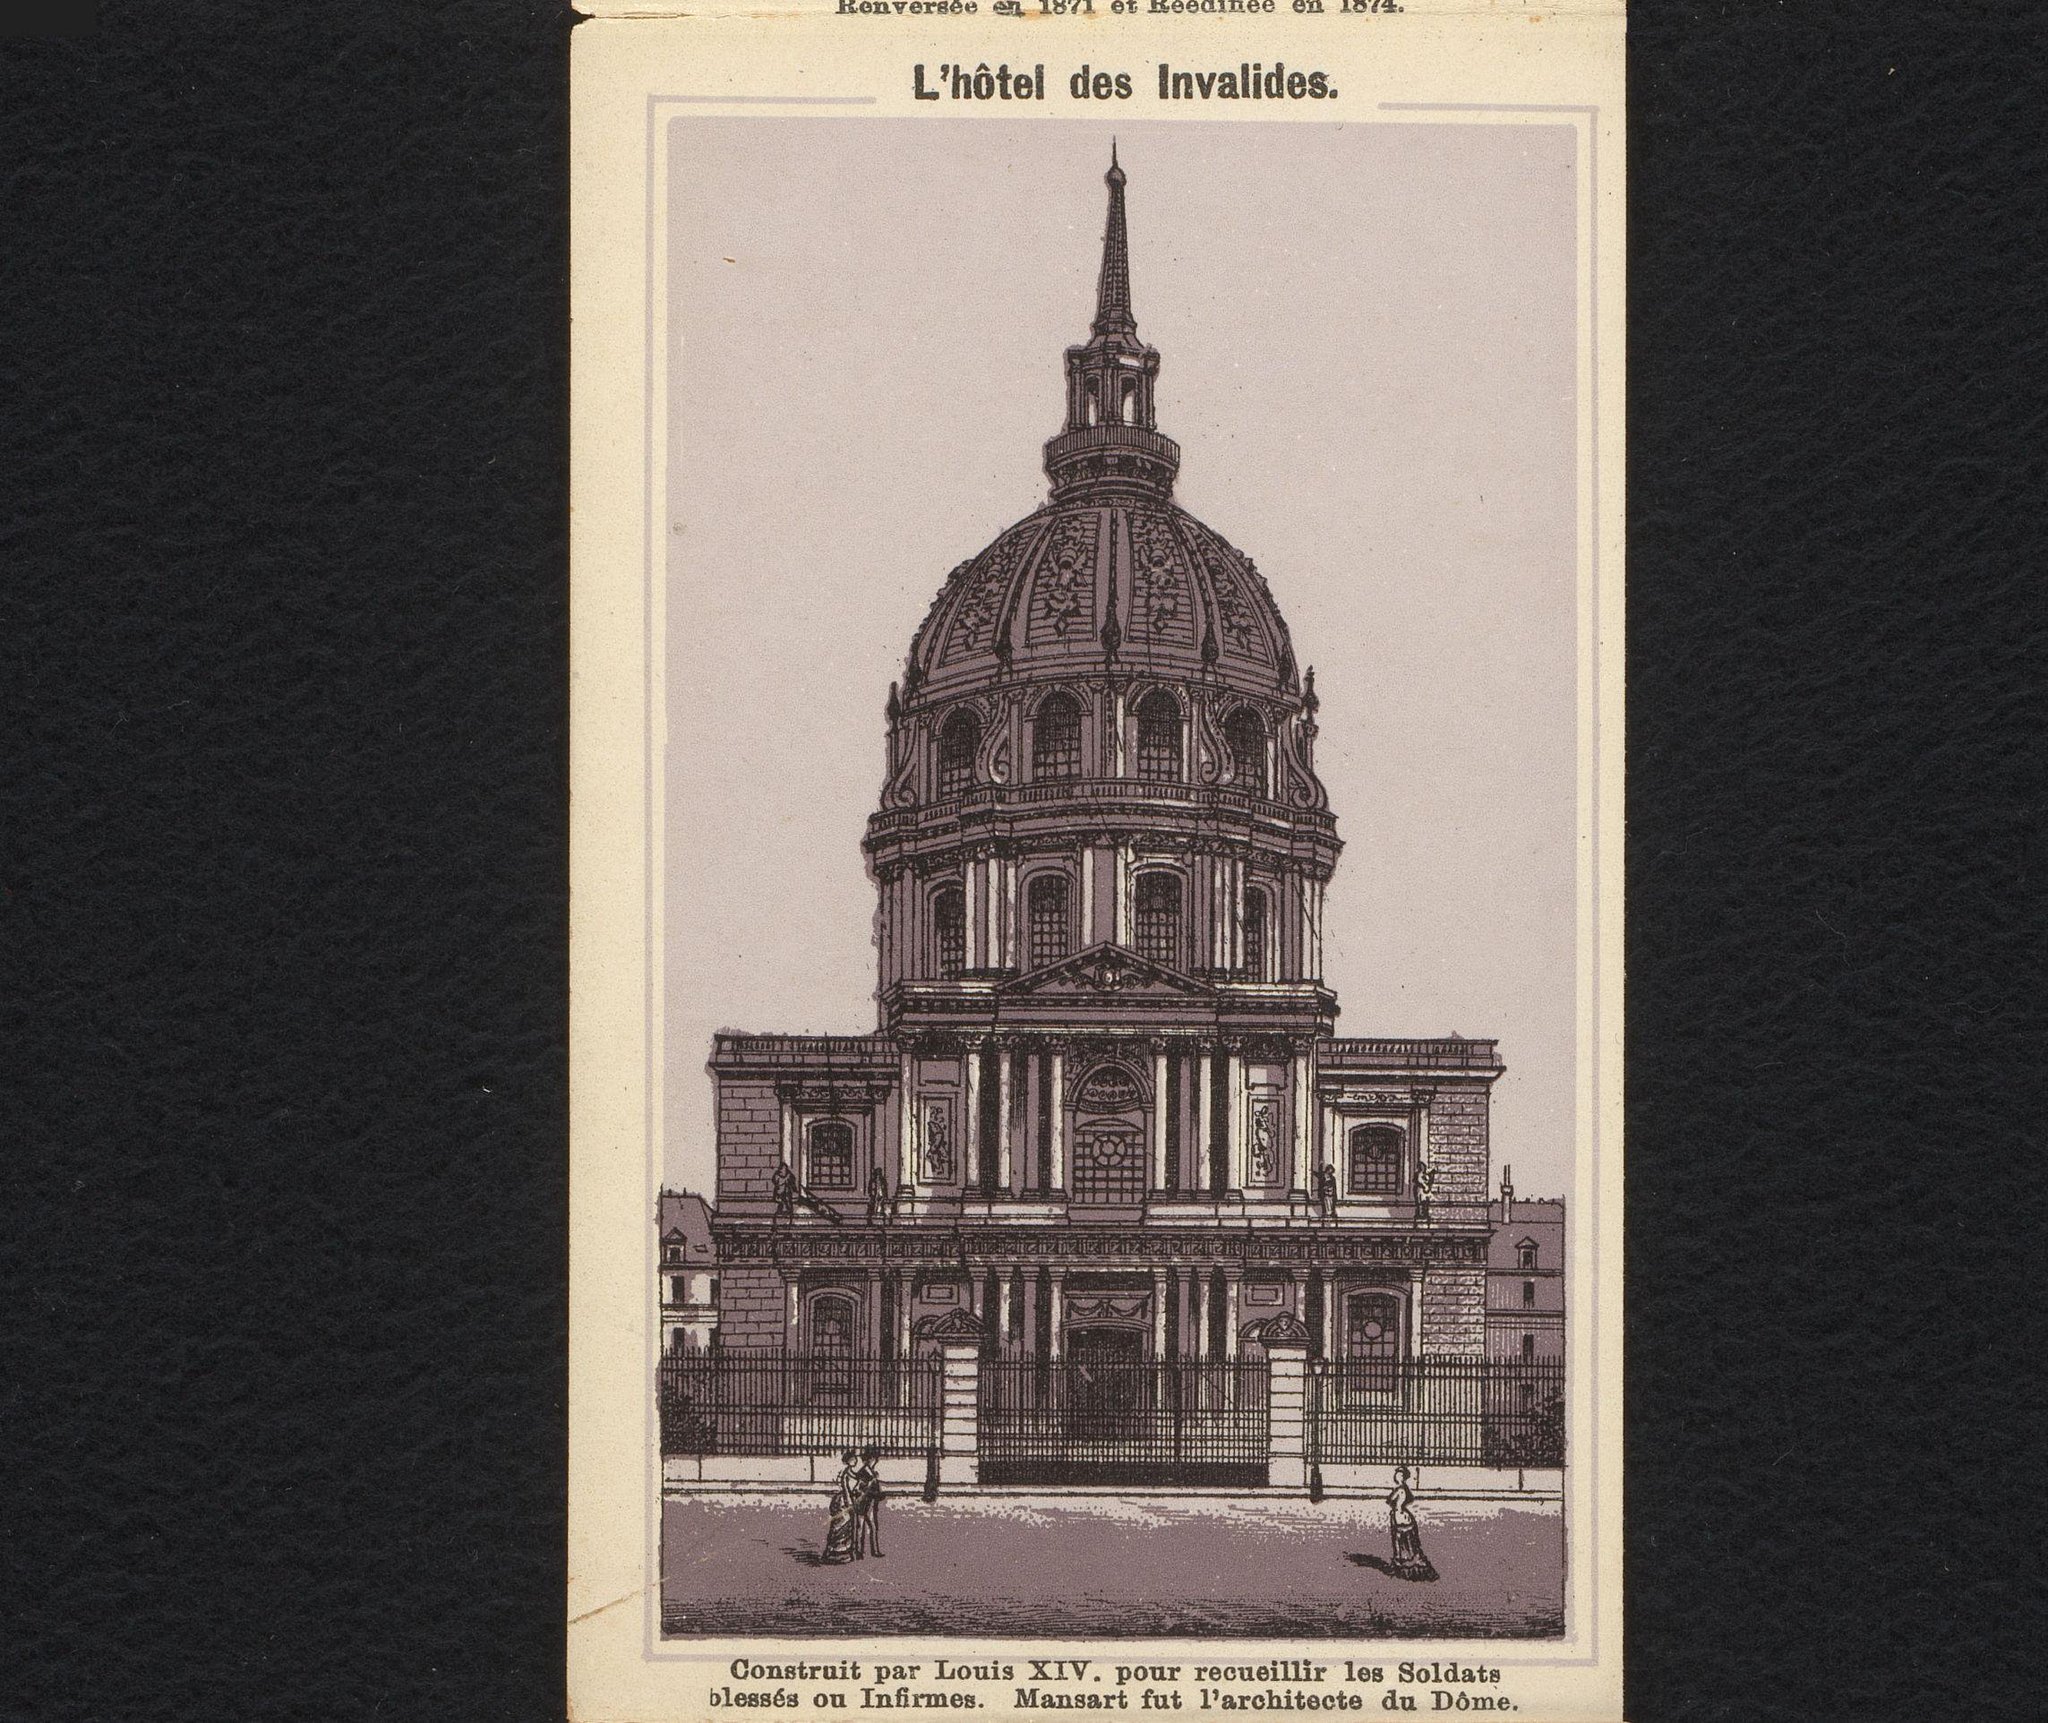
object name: print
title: L'Hôtel des Invalides. Construit par Louis XIV pour recueillir les Soldats blessés ou infirmes (...)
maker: Anonymous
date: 1890-1910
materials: cardboard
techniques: lithograph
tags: exterior ~ representation of a building, dome ~ architecture, square, place, circus, etc. (+ city(-scape) with figures, staffage)